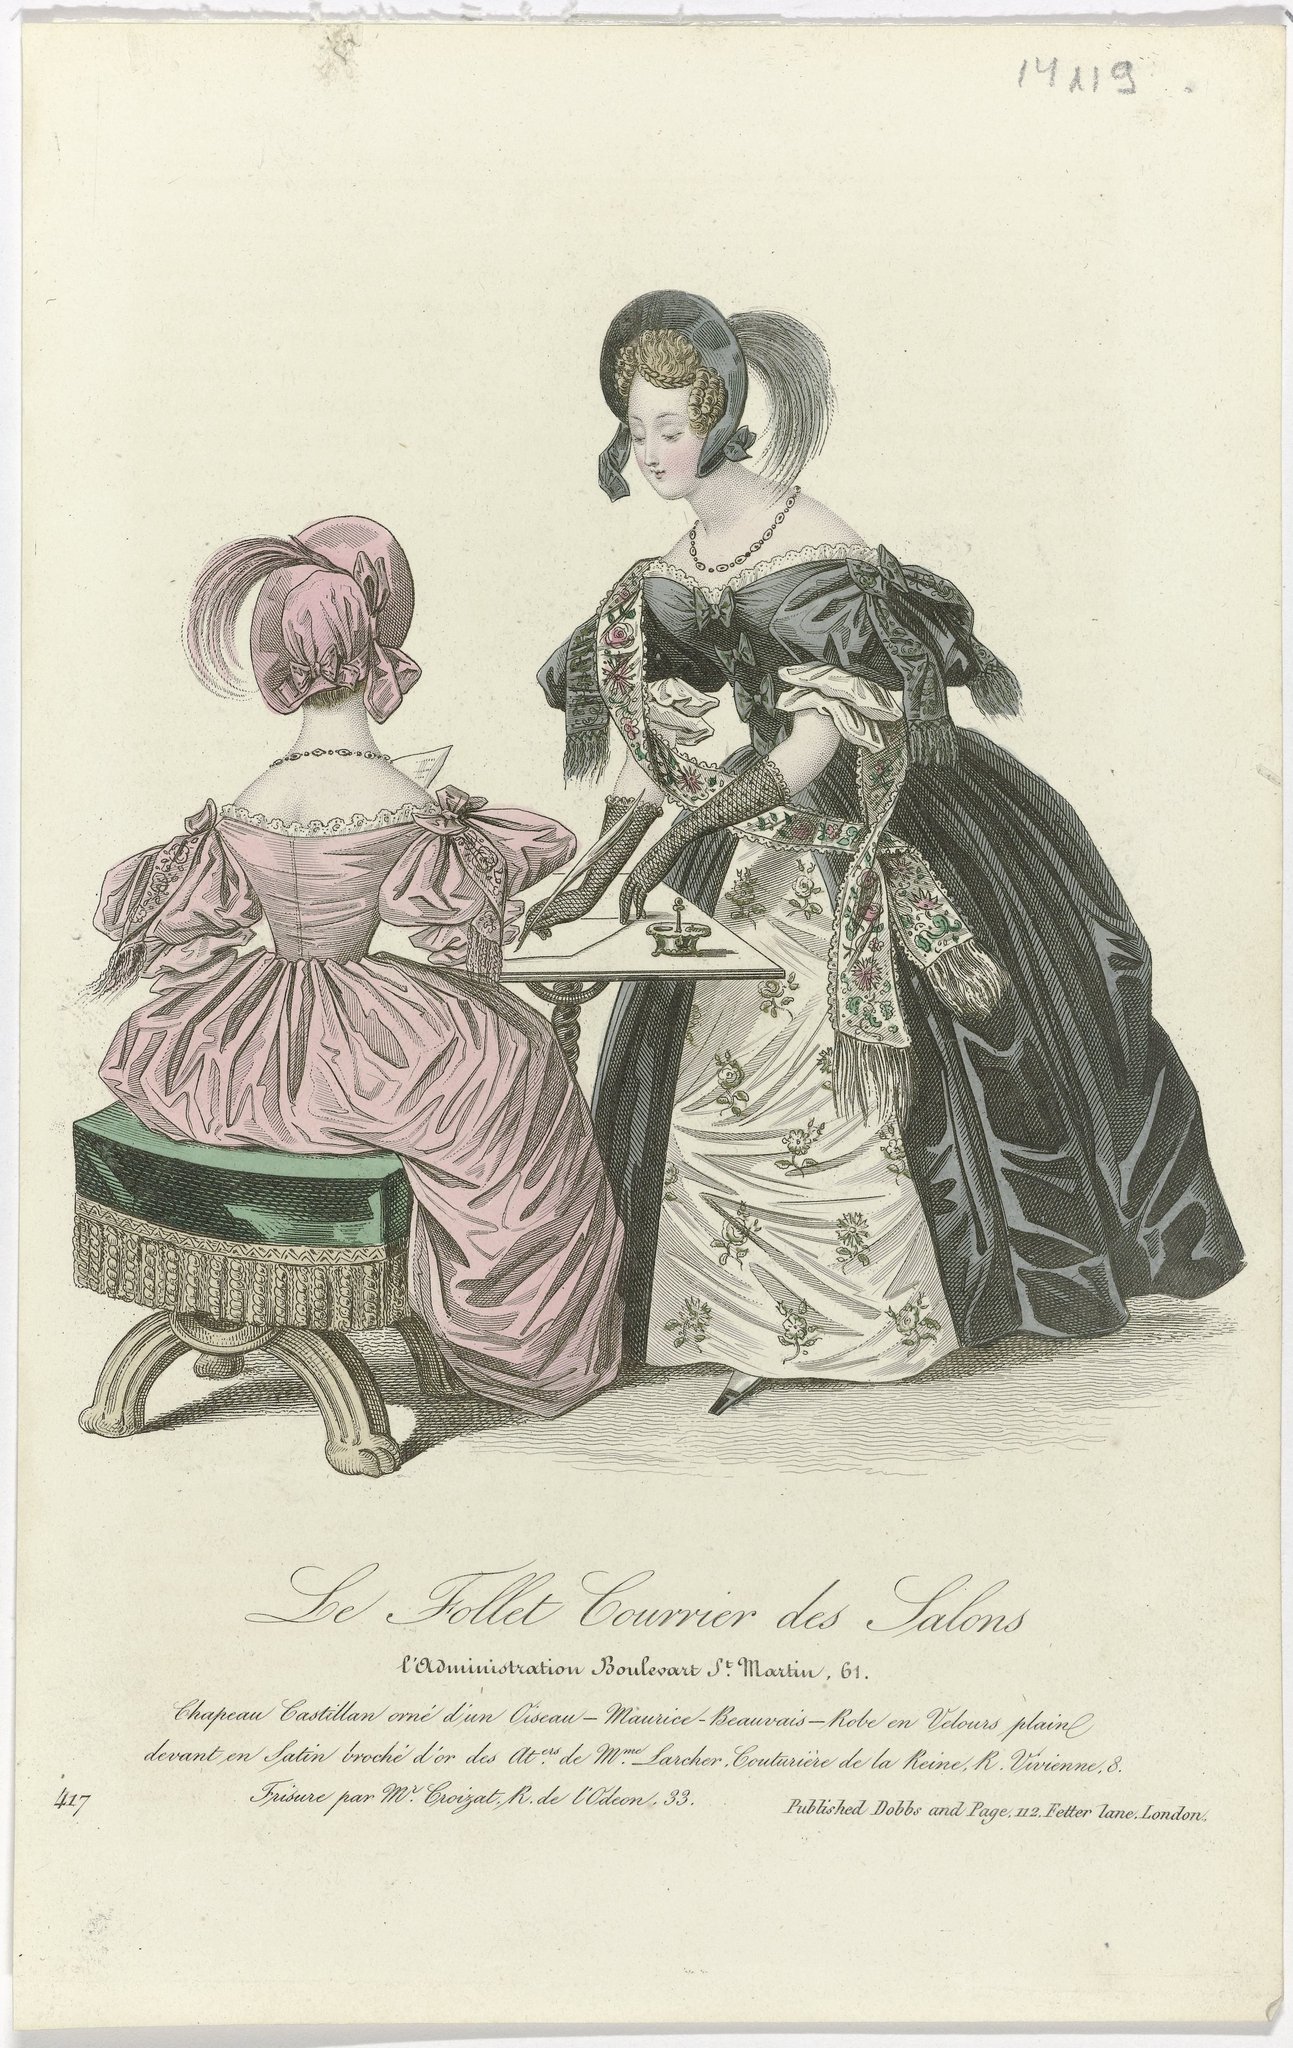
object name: fashion print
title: Le Follet Courrier des Salons, 1835, No. 417: Chapeau Castillan (...)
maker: Anonymous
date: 1835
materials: paper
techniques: engraving, hand coloring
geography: london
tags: clothing for the upper part of the body (shawl) (+ women's clothes), quill, gold-thread embroidery (+ women's clothes), styles of hairdress - aa - ~ women, fashion plates, head-gear: hat (+ women's clothes), gloves, mittens, etc. (+ women's clothes), dress, gown (+ women's clothes), necklace (+ women's clothes), head-gear: hat (+ feathers used for clothes)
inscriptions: caption: ‘Chapeau Castillan orné d'un Oiseau - Maurice-Beauvais - Robe en Velours plain devant en Satin broché d'or des At.ers de M.me Larcher. Couturière de la Reine, R. Vivienne, 8. Frisure par M.r Croizat. R. de l'Odeon. 33.’, address: ‘L'Administration Boulevart S.t Martin, 61 / Published Dobbs and Page, 112, Fetter lane, London.’, title: ‘Le Follet Courrier des Salons’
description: Vrouw met schrijfveer in de hand, staande bij een tafel waarop een papier en pot inkt. Volgens het onderschrift: 'chapeau Castillan' versierd met veren van de paradijsvogel. Japon van 'velours plain' op 'satin broché d'or' uit de winkels van Larcher, 'Couturière de la Reine'. Krullen door Croizat. Figuur in eenzelfde japon, op de rug gezien, zittend op een tabouret. Prent uit het modetijdschrift Le Follet Courrier des Salons (novembre 1829- octobre 1882).